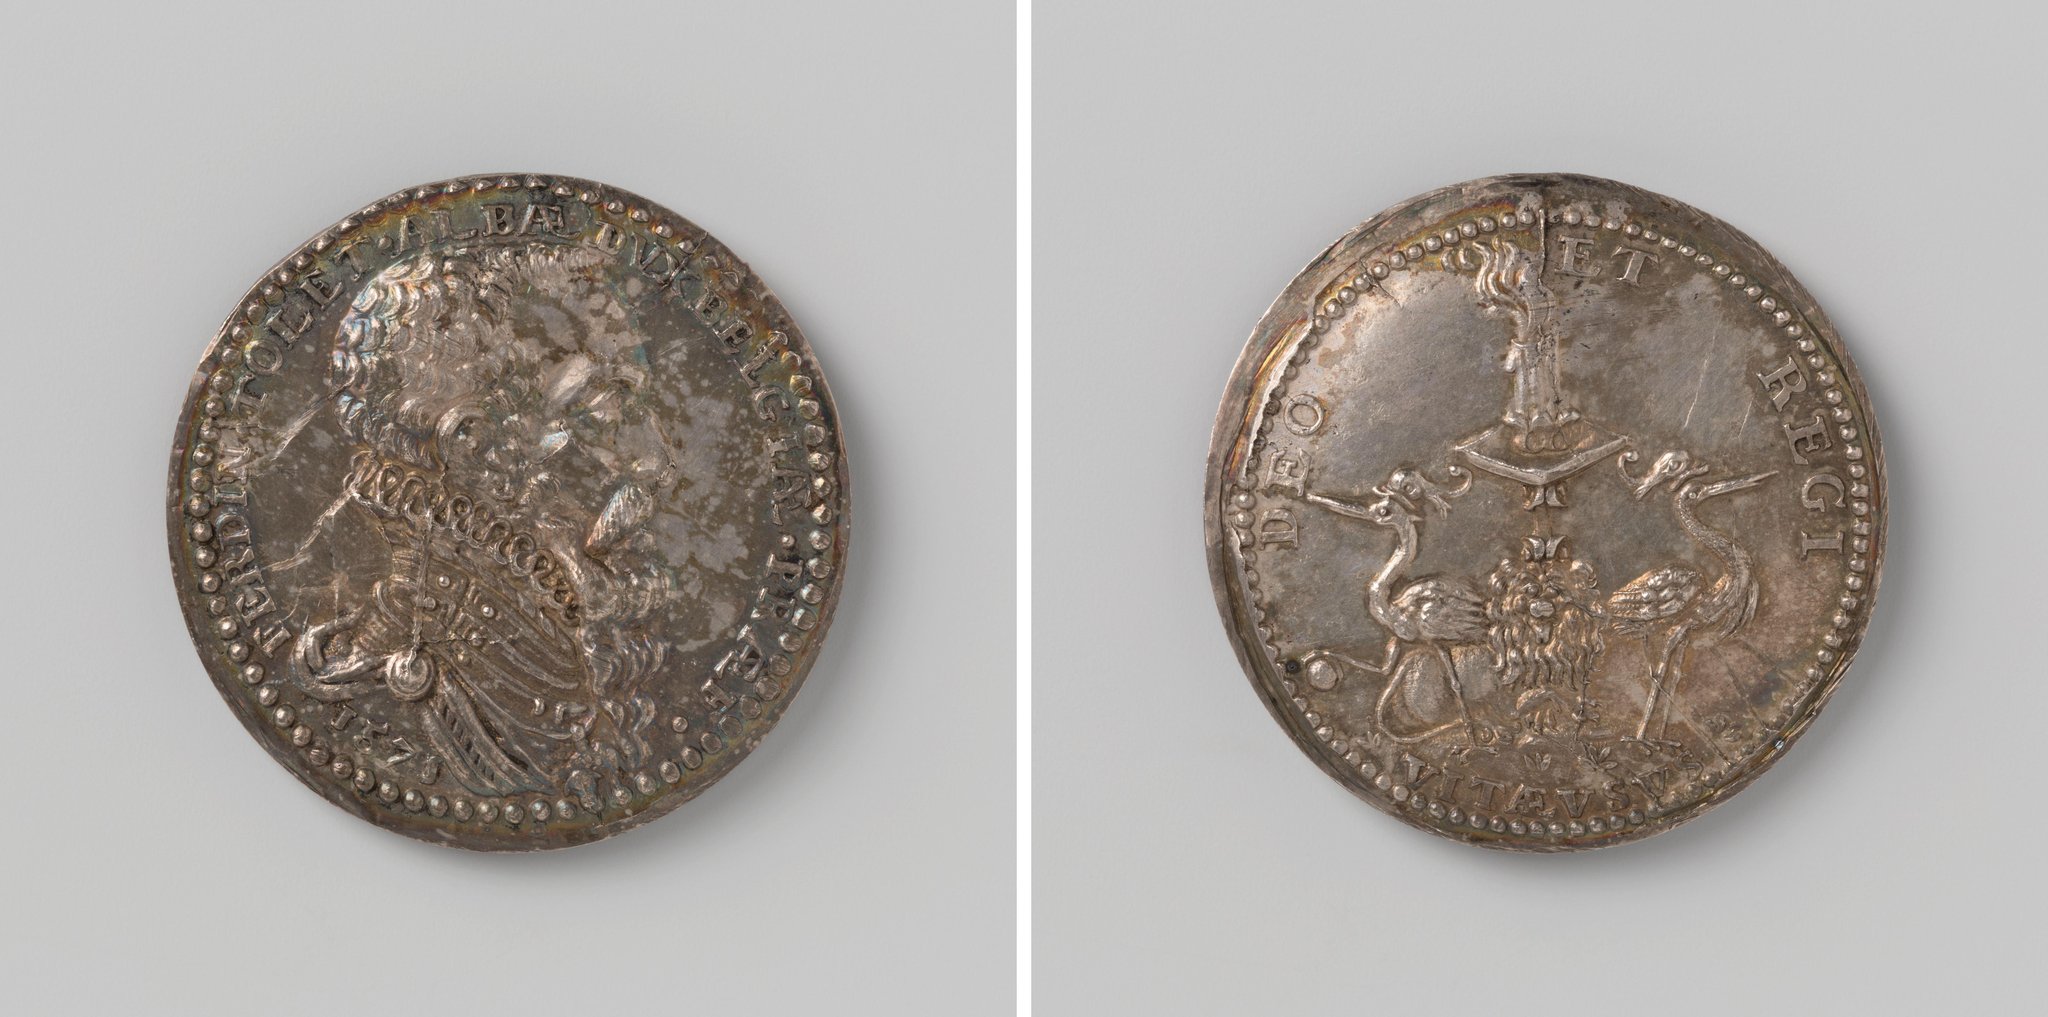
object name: history medal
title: Ferdinand van Toledo, hertog van Alva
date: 1571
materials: silver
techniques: striking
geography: antwerp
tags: fernando álvarez de toledo (3rd duke of alba)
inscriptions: circumscription: ‘FERD ALB DVX CASTROR PRAEF / 1571’, circumscription: ‘DEO ET REGI / VITAE VSVS’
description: Zilveren penning. Voorzijde: borststuk man binnen omschrift. Keerzijde: brandend altaar gedragen door liggende leeuw en twee kraanvogels binnen omschrift.